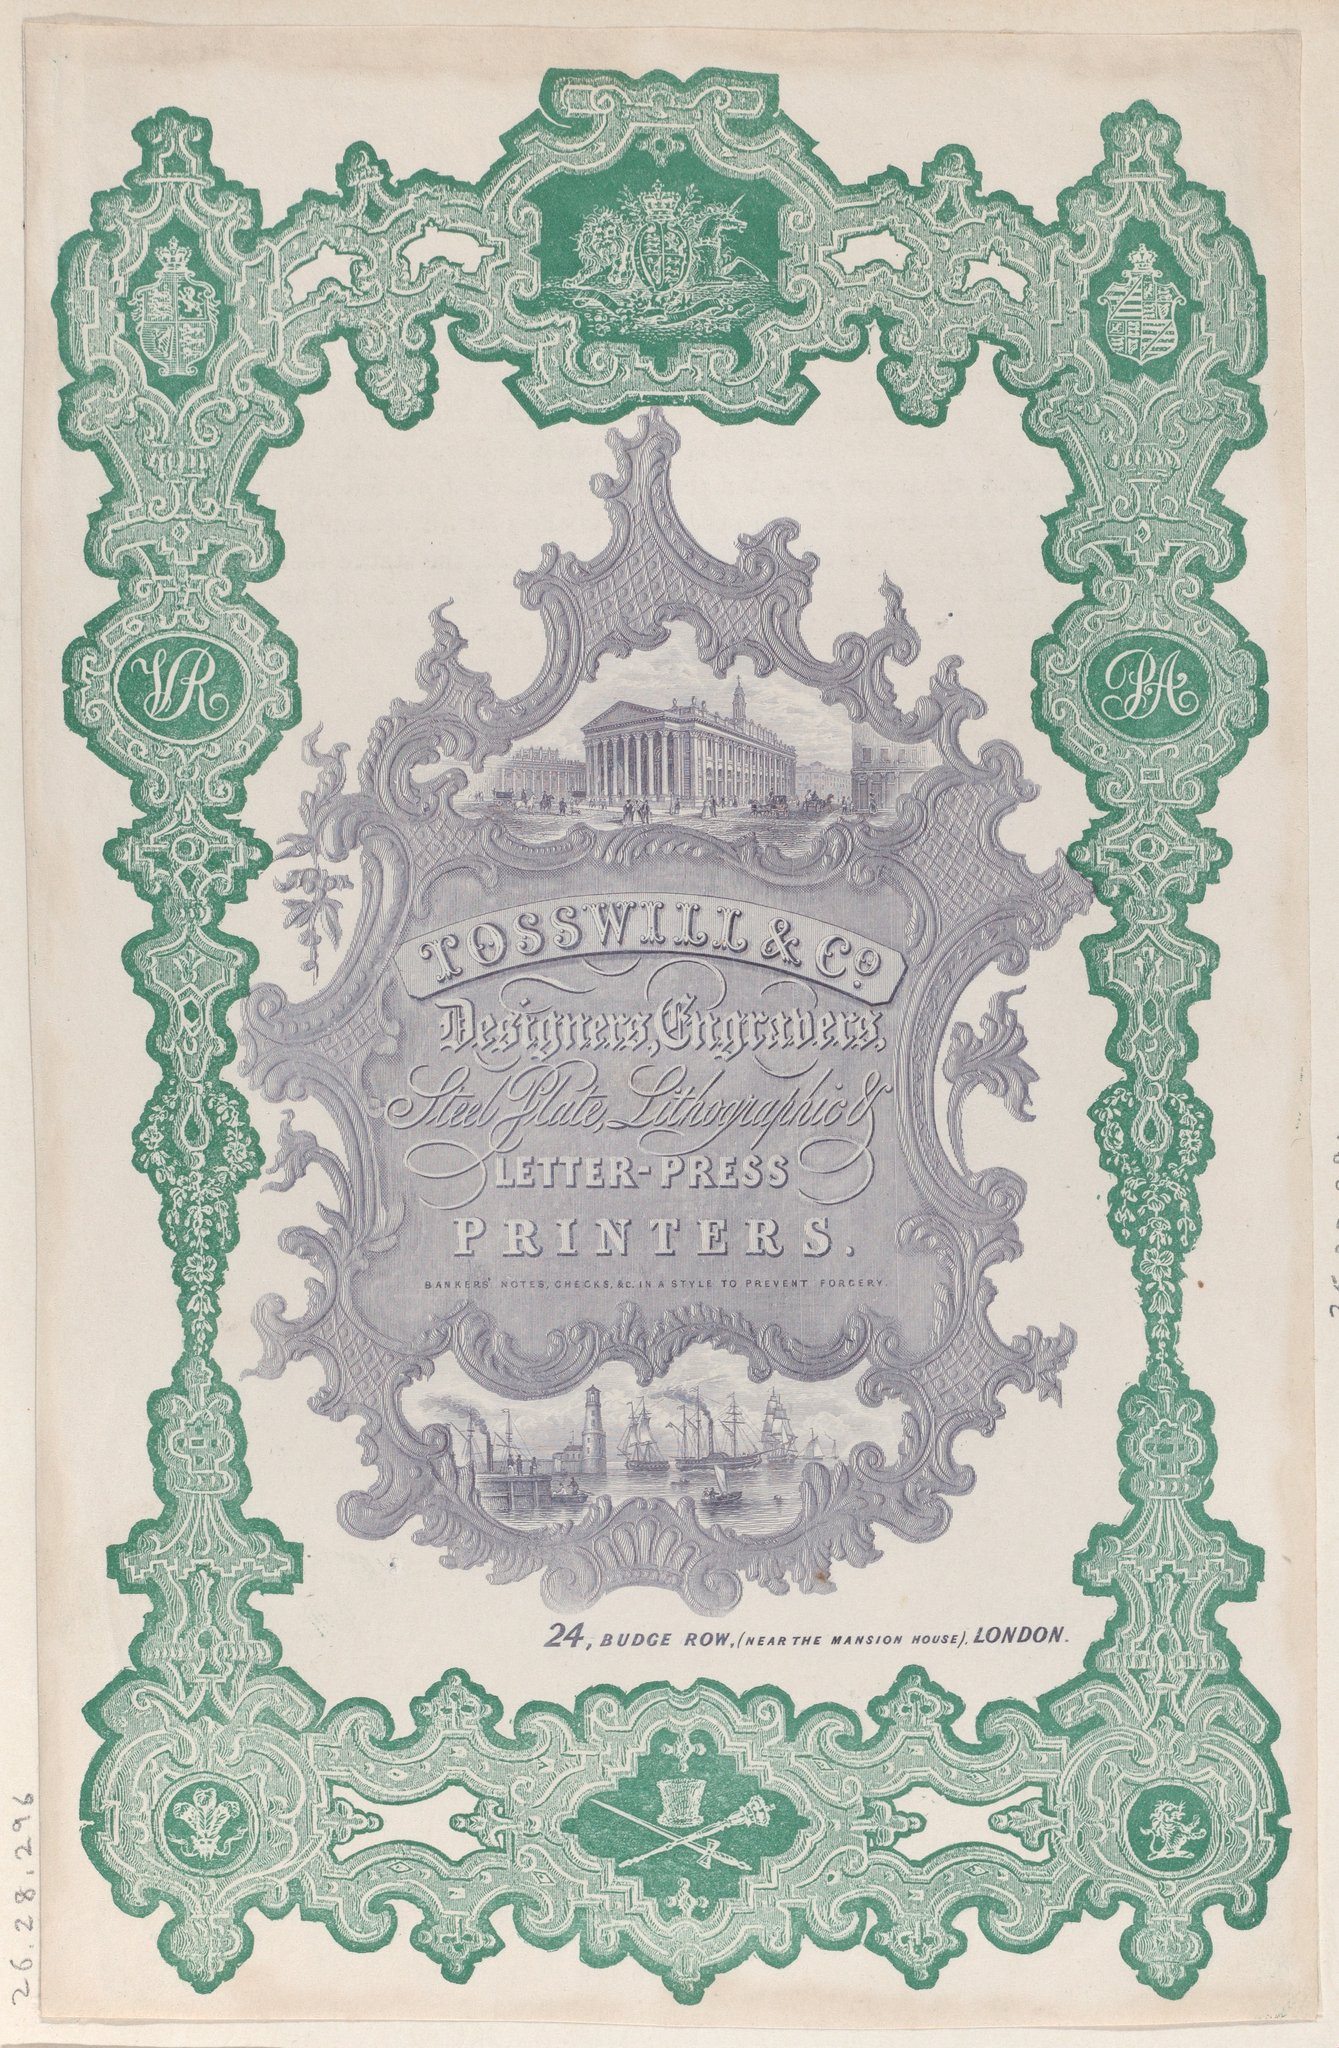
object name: print, trade card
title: Trade Card for Tosswill & Co., Designers, Engravers, Steel Plate, Lithographic & Letterpress Printers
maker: anonymous, british, 19th century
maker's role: artist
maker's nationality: british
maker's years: 1800-1900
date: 1801-1900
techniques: lithograph